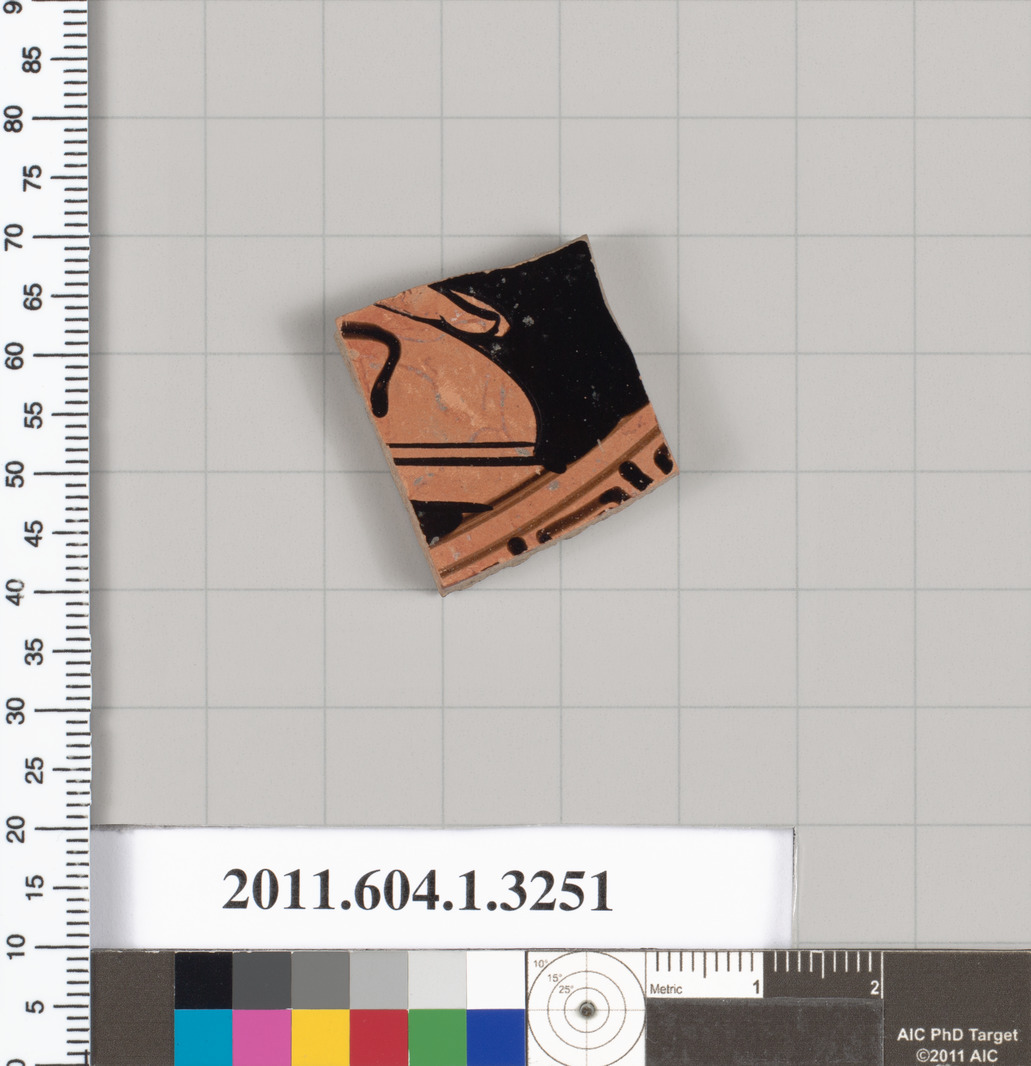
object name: kylix fragment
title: Terracotta fragment of a kylix (drinking cup)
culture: greek, attic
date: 490-470 BCE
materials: terracotta